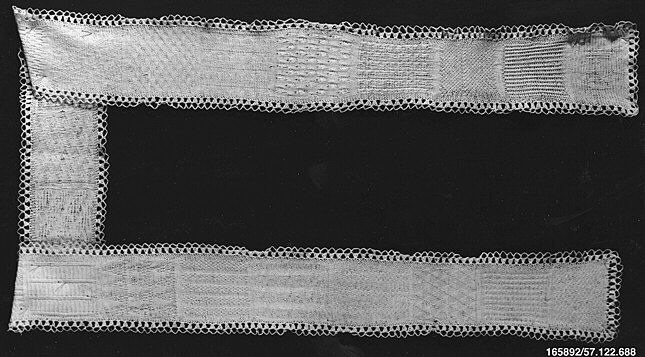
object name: sampler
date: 1801-1900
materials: cotton, lace